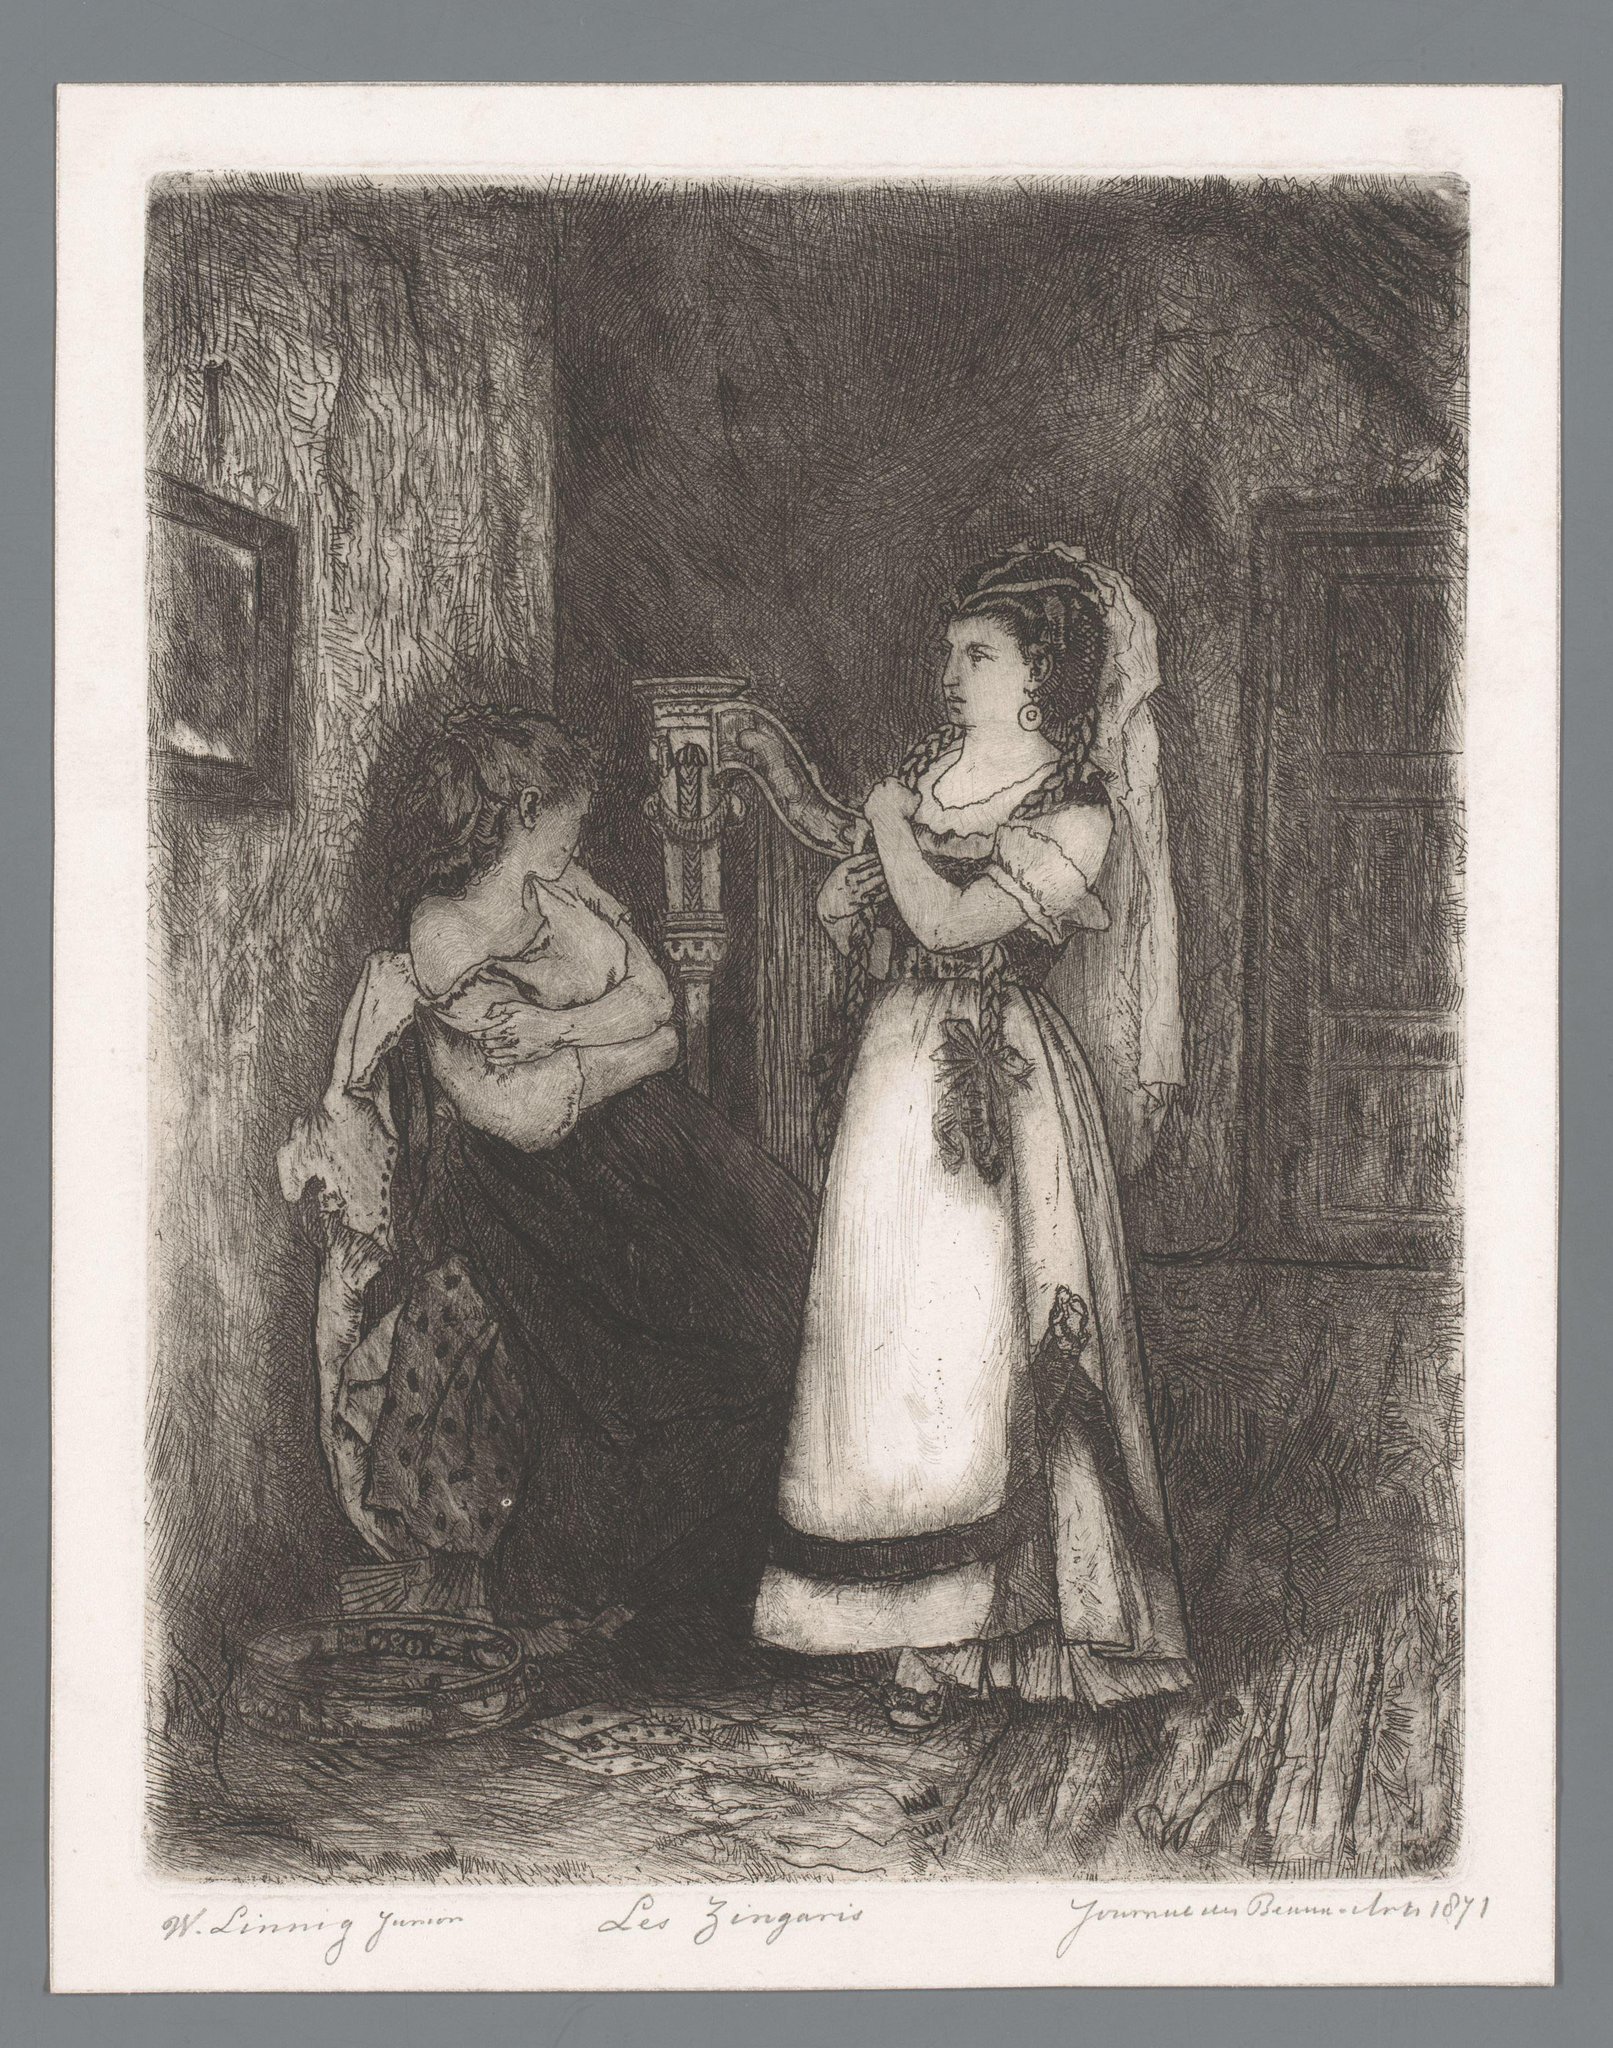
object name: print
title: Twee Romavrouwen in een vertrek met een harp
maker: willem linnig (ii)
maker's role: print maker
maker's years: 1842-1890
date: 1871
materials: paper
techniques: etching, intaglio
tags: tambourine, wandering communities: romani or roma, harp, playing-cards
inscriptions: collector's mark: Lugt 2228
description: Prent gebruikt in: Journal des Beaux-arts (1871).